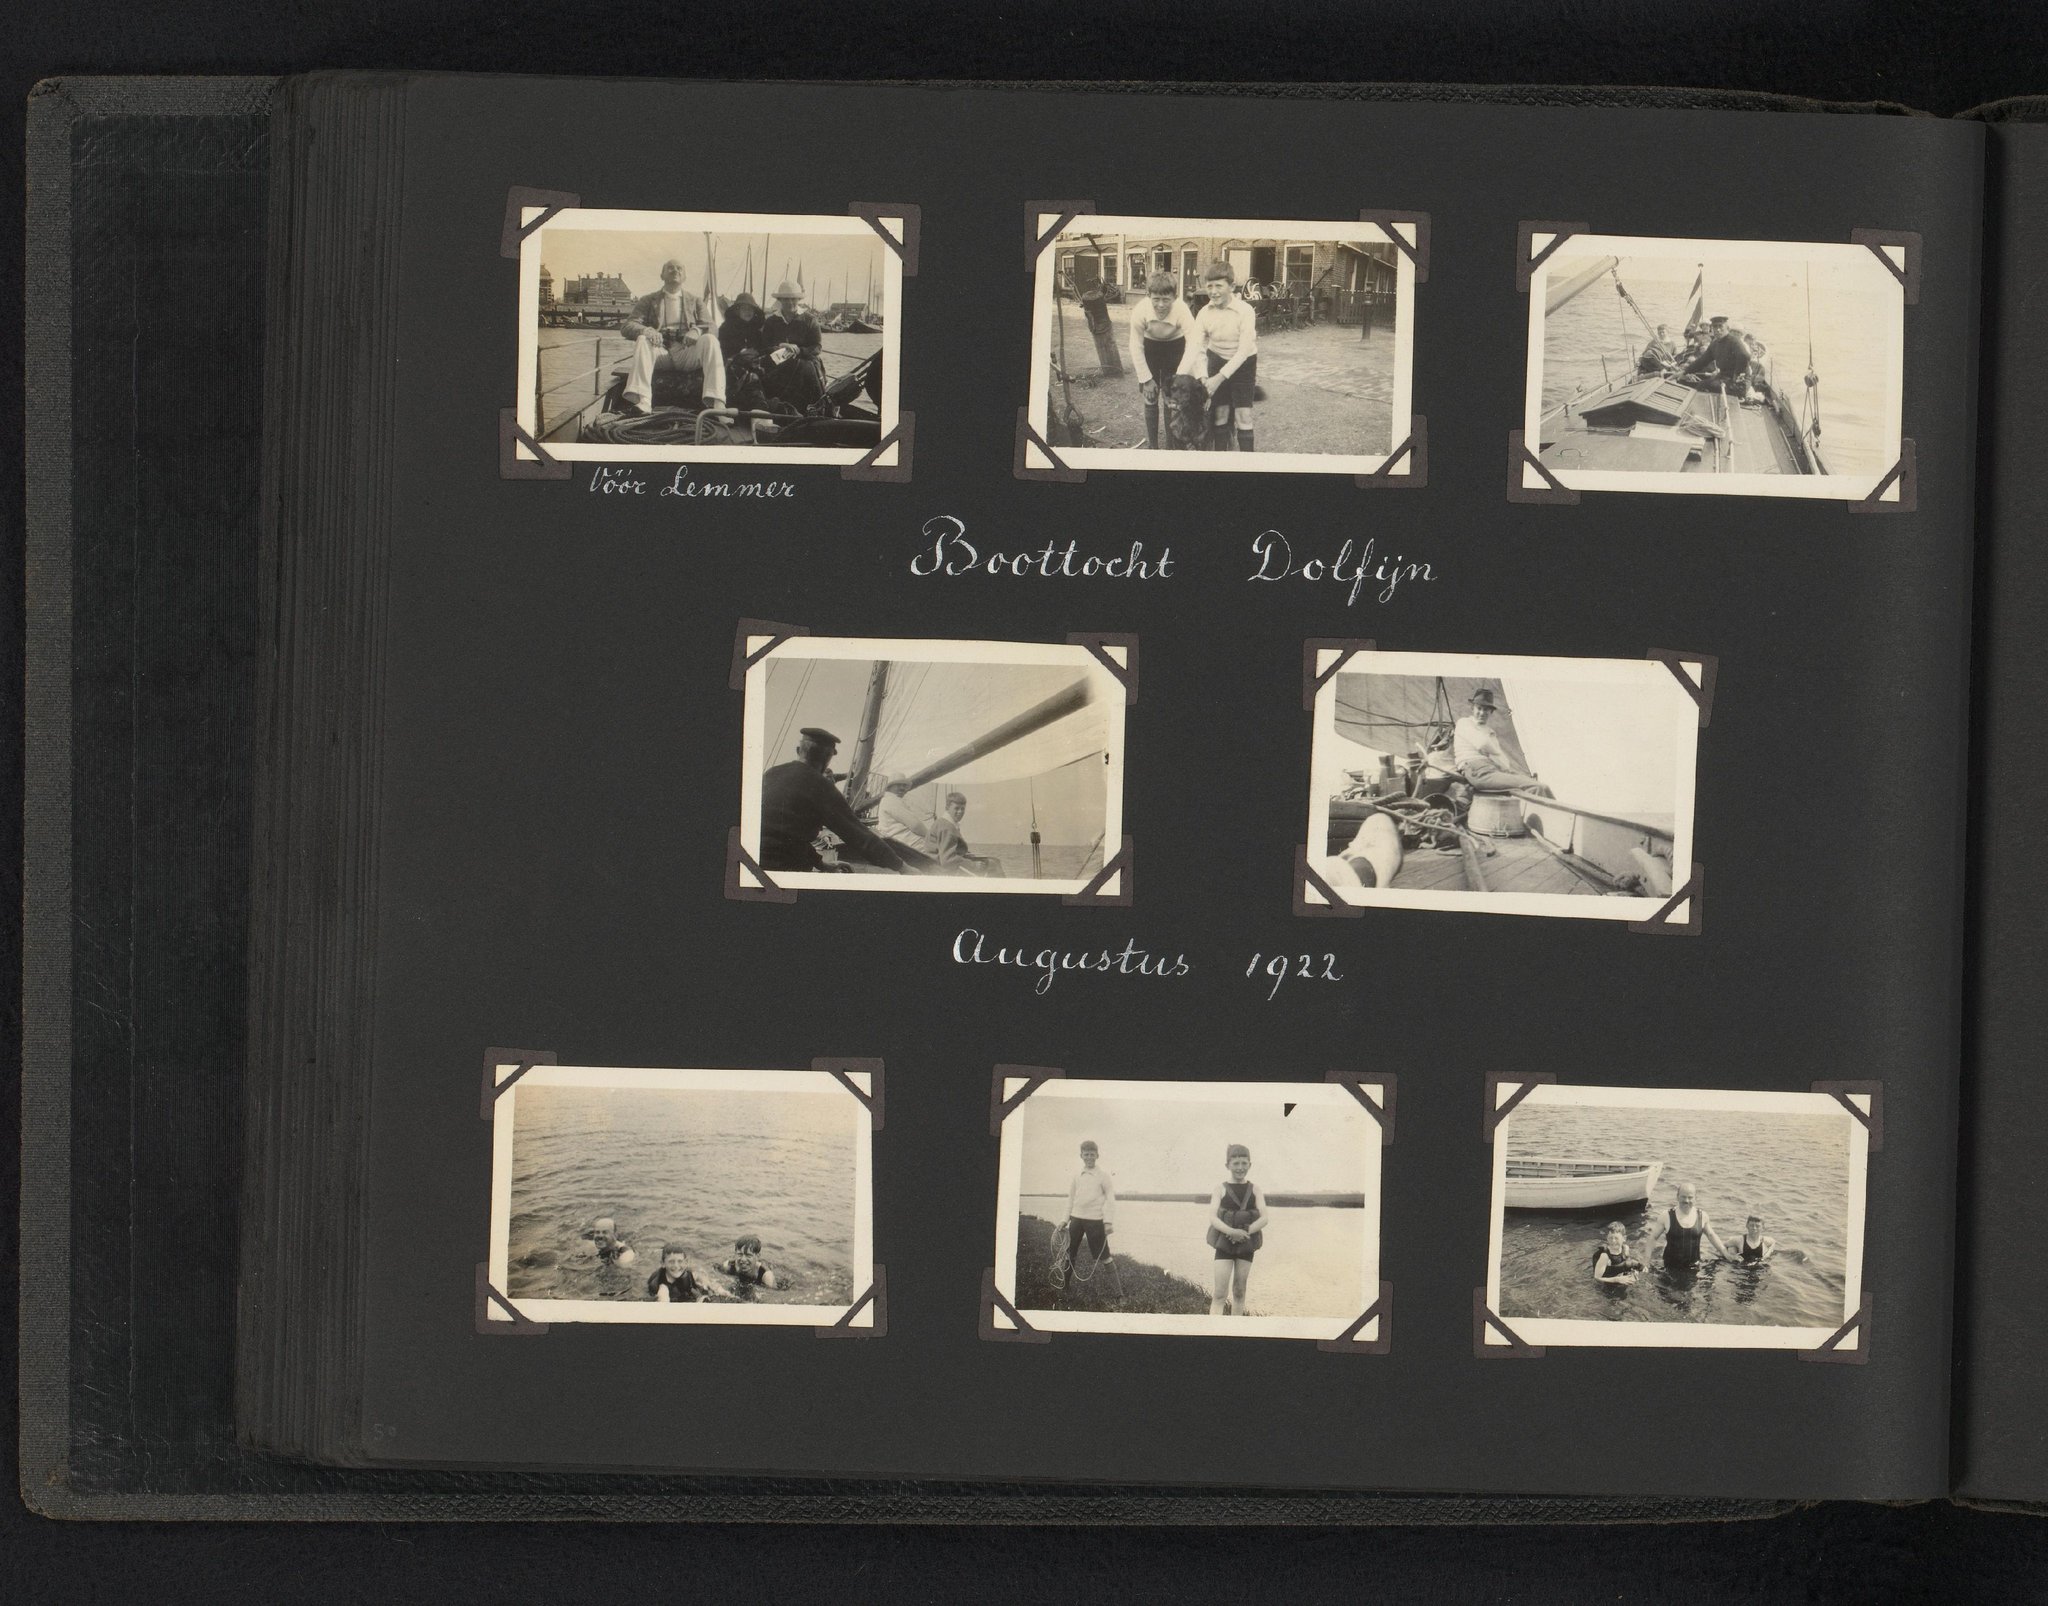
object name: album leaf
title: Acht foto's van de familie Van den Berg op een boottocht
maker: hendrik herman van den berg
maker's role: amateurfotograaf, jurist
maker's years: 1875-1944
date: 1908-1922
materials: paper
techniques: gelatin silver print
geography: friesland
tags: batavia, amsterdam, hendrik herman van den berg, the hague, caroline louise van den berg-van den berg, carel frederik van den berg (cay), frank willem van den berg (1912-1998), sailing-ship, sailing-boat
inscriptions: inscription: ‘Vóór Lemmer’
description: Deze foto's maken deel uit van een album.